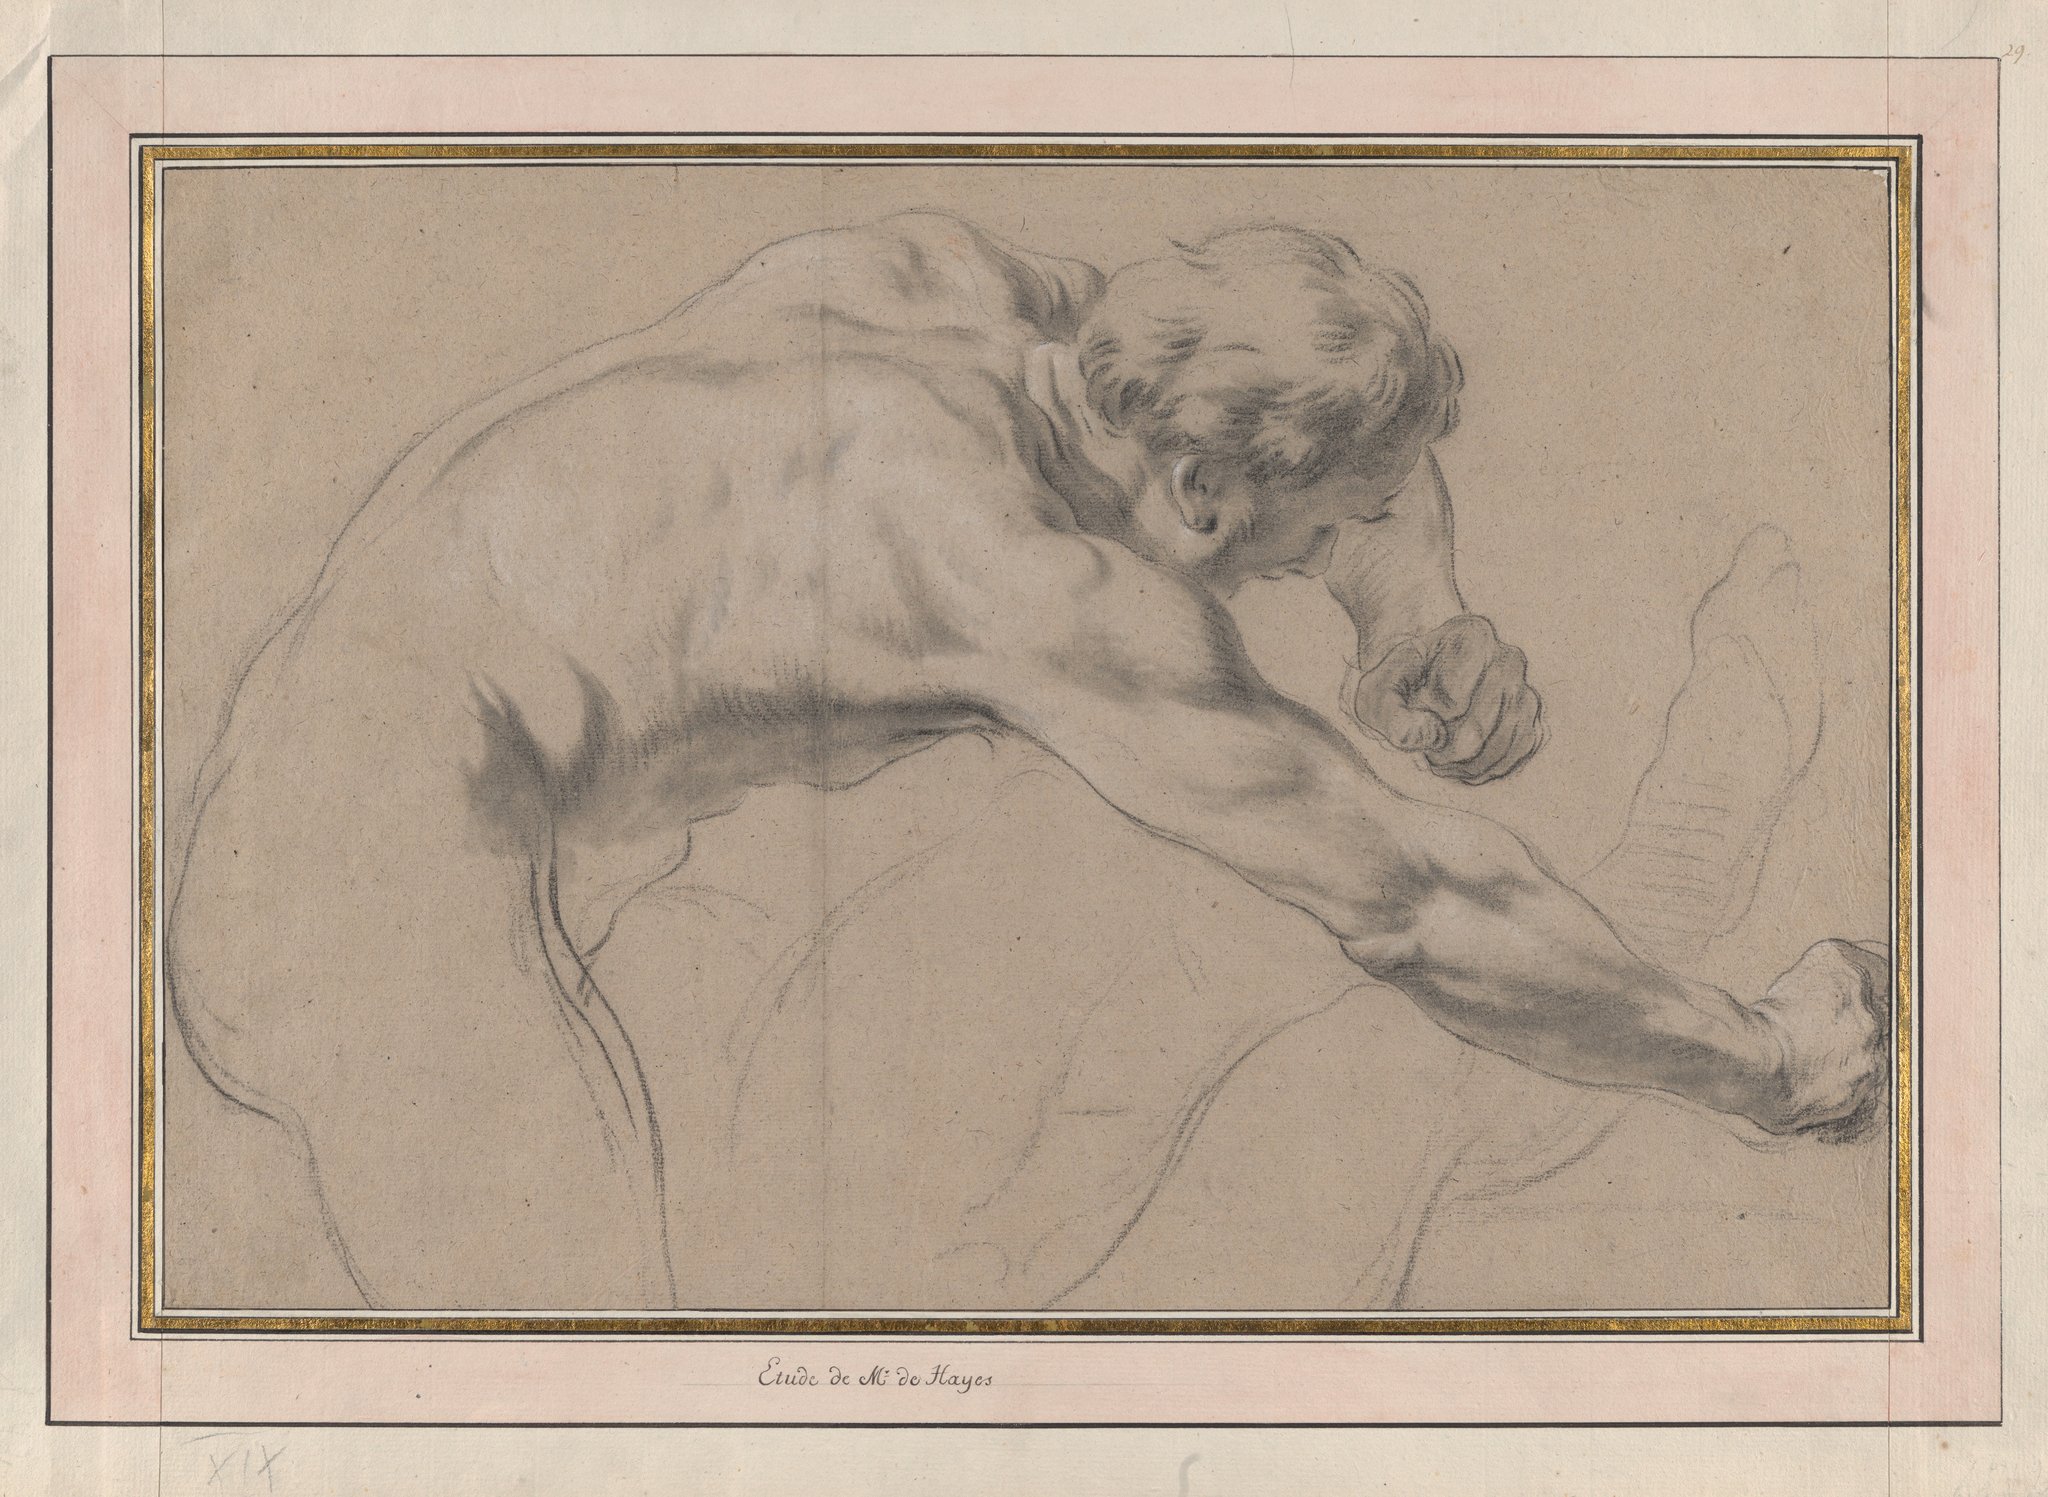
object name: drawing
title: Male Nude, Study for Samson and Delilah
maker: jacques francois amand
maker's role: artist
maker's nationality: french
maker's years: 1730-1769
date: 1730-1769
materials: chalk, paper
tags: male nudes